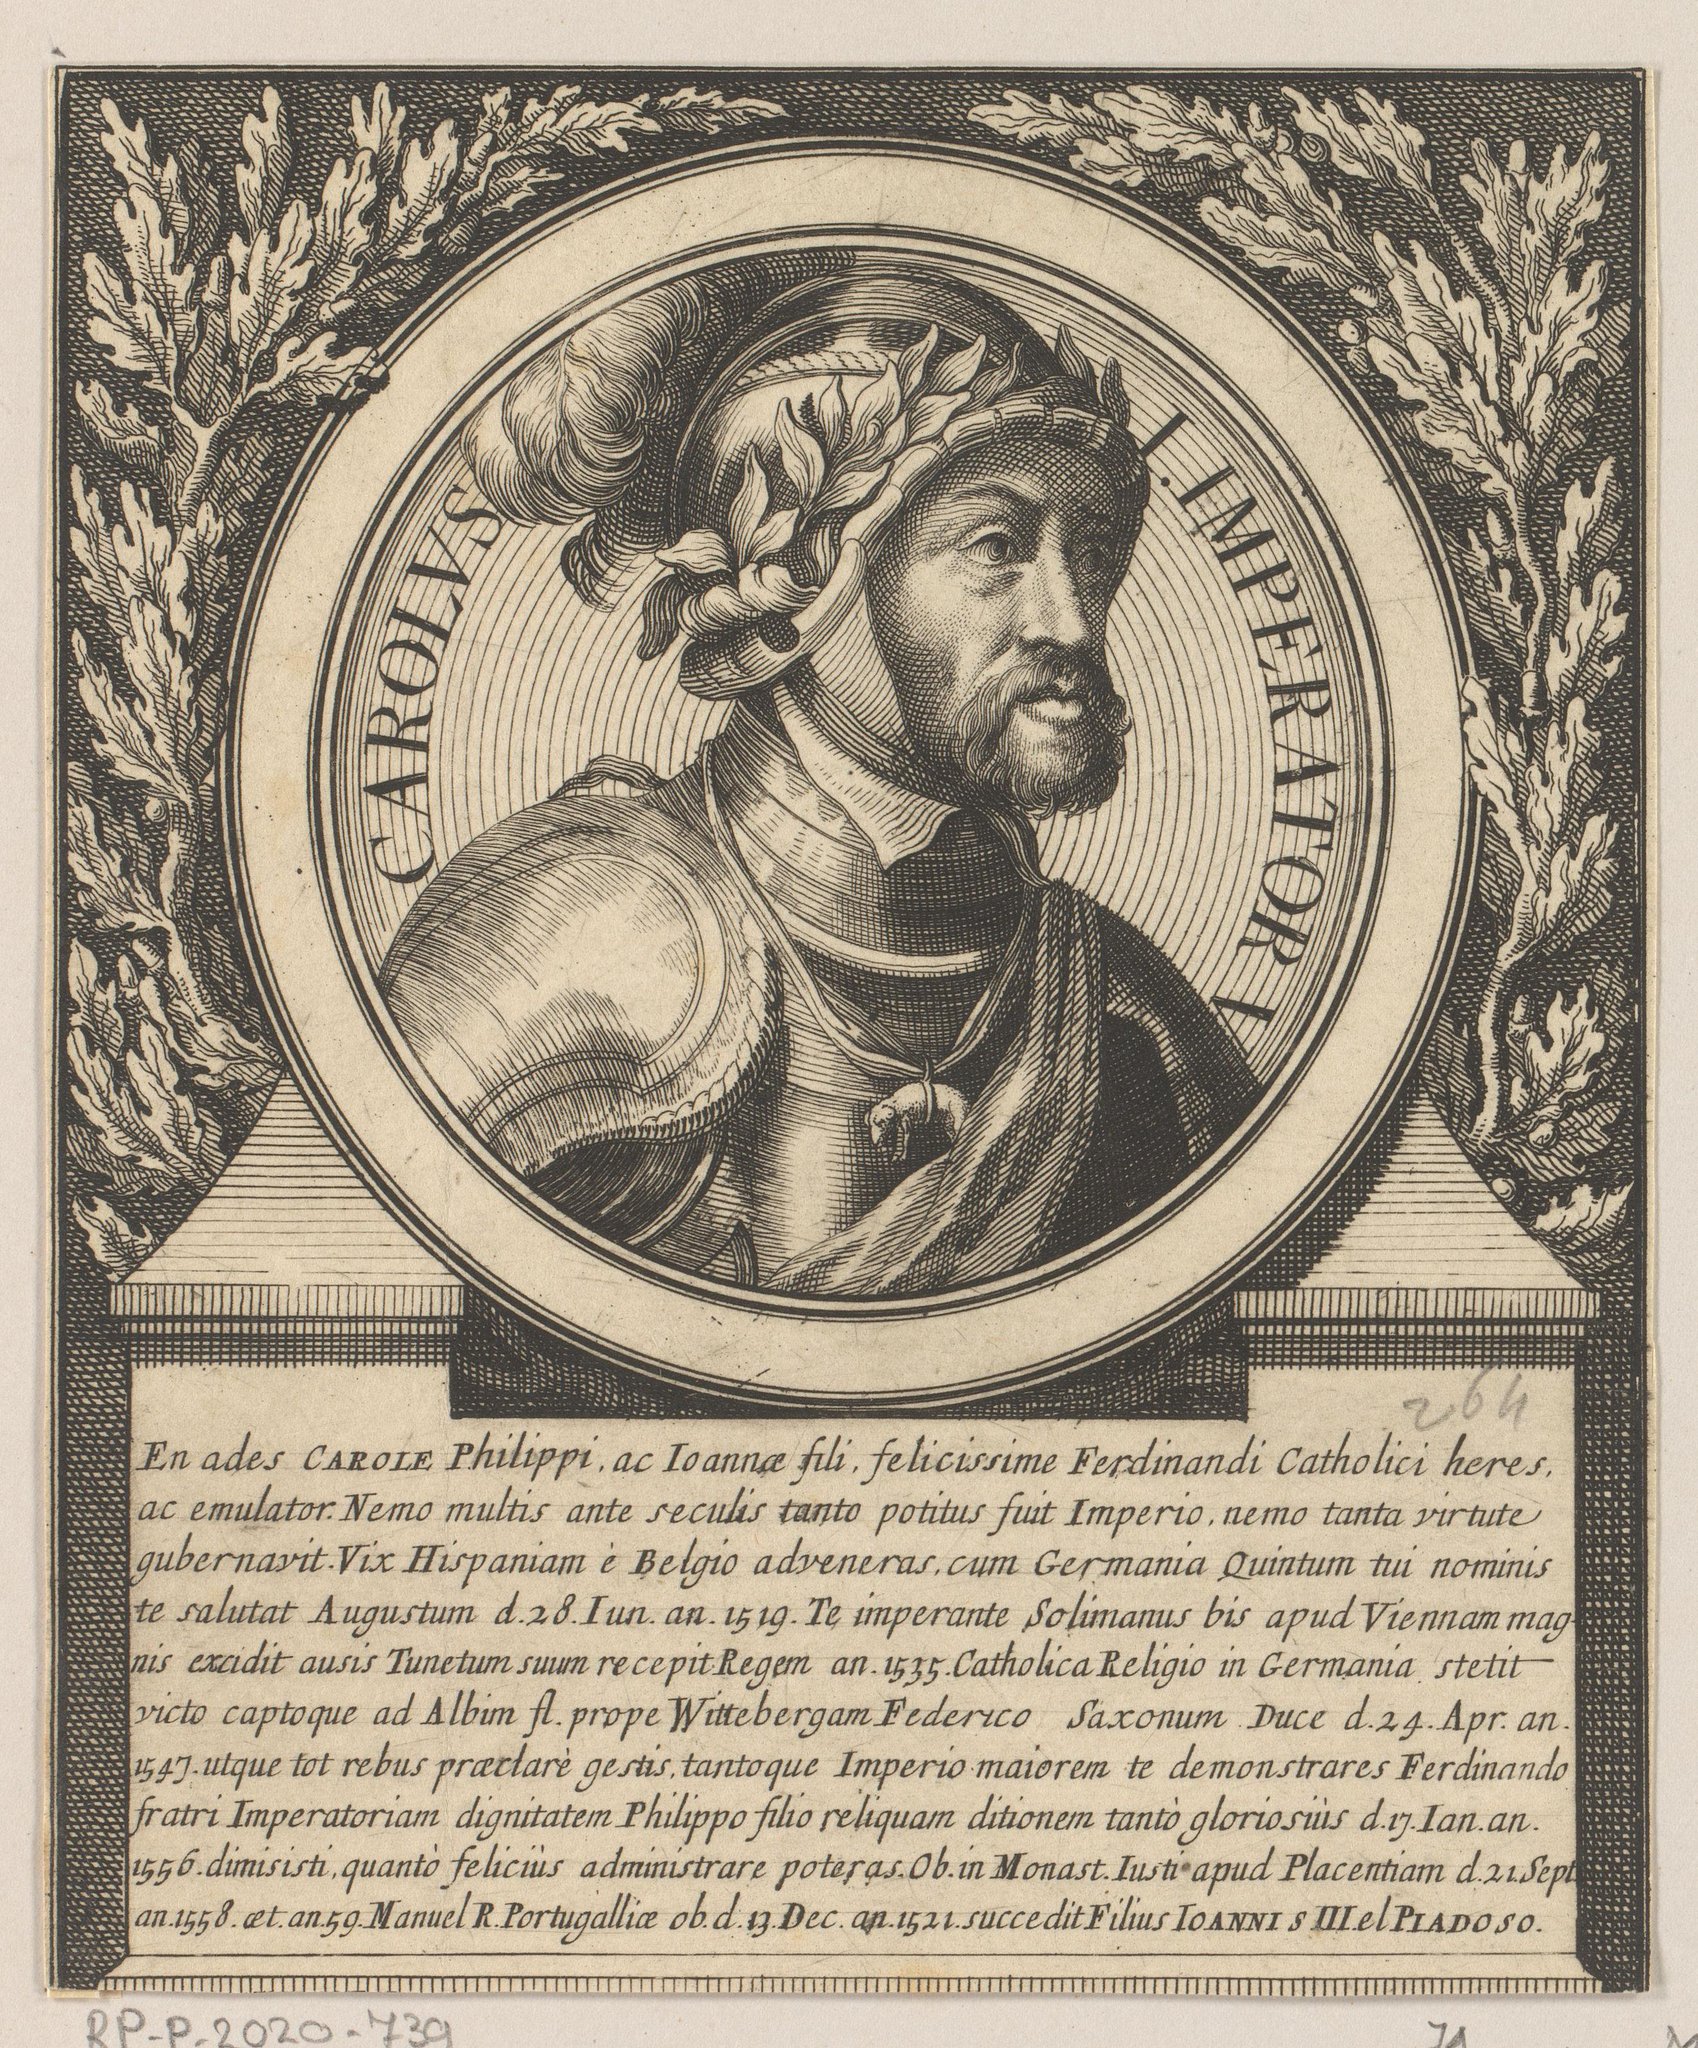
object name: print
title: Carolus I. Imperator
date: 1698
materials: paper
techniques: engraving, etching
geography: paris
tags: ghent, charles v (holy roman emperor and king of spain), historical persons, ruler, sovereign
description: Portret afkomstig van een grote prent, getiteld 'Series Chronologica et Imagines Regum Hispaniae ab Ataulpho ad Carolum II', bestaande uit meerdere bladen die samengevoegd konden worden, uitgegeven door Petrus de la Tour in 1698.